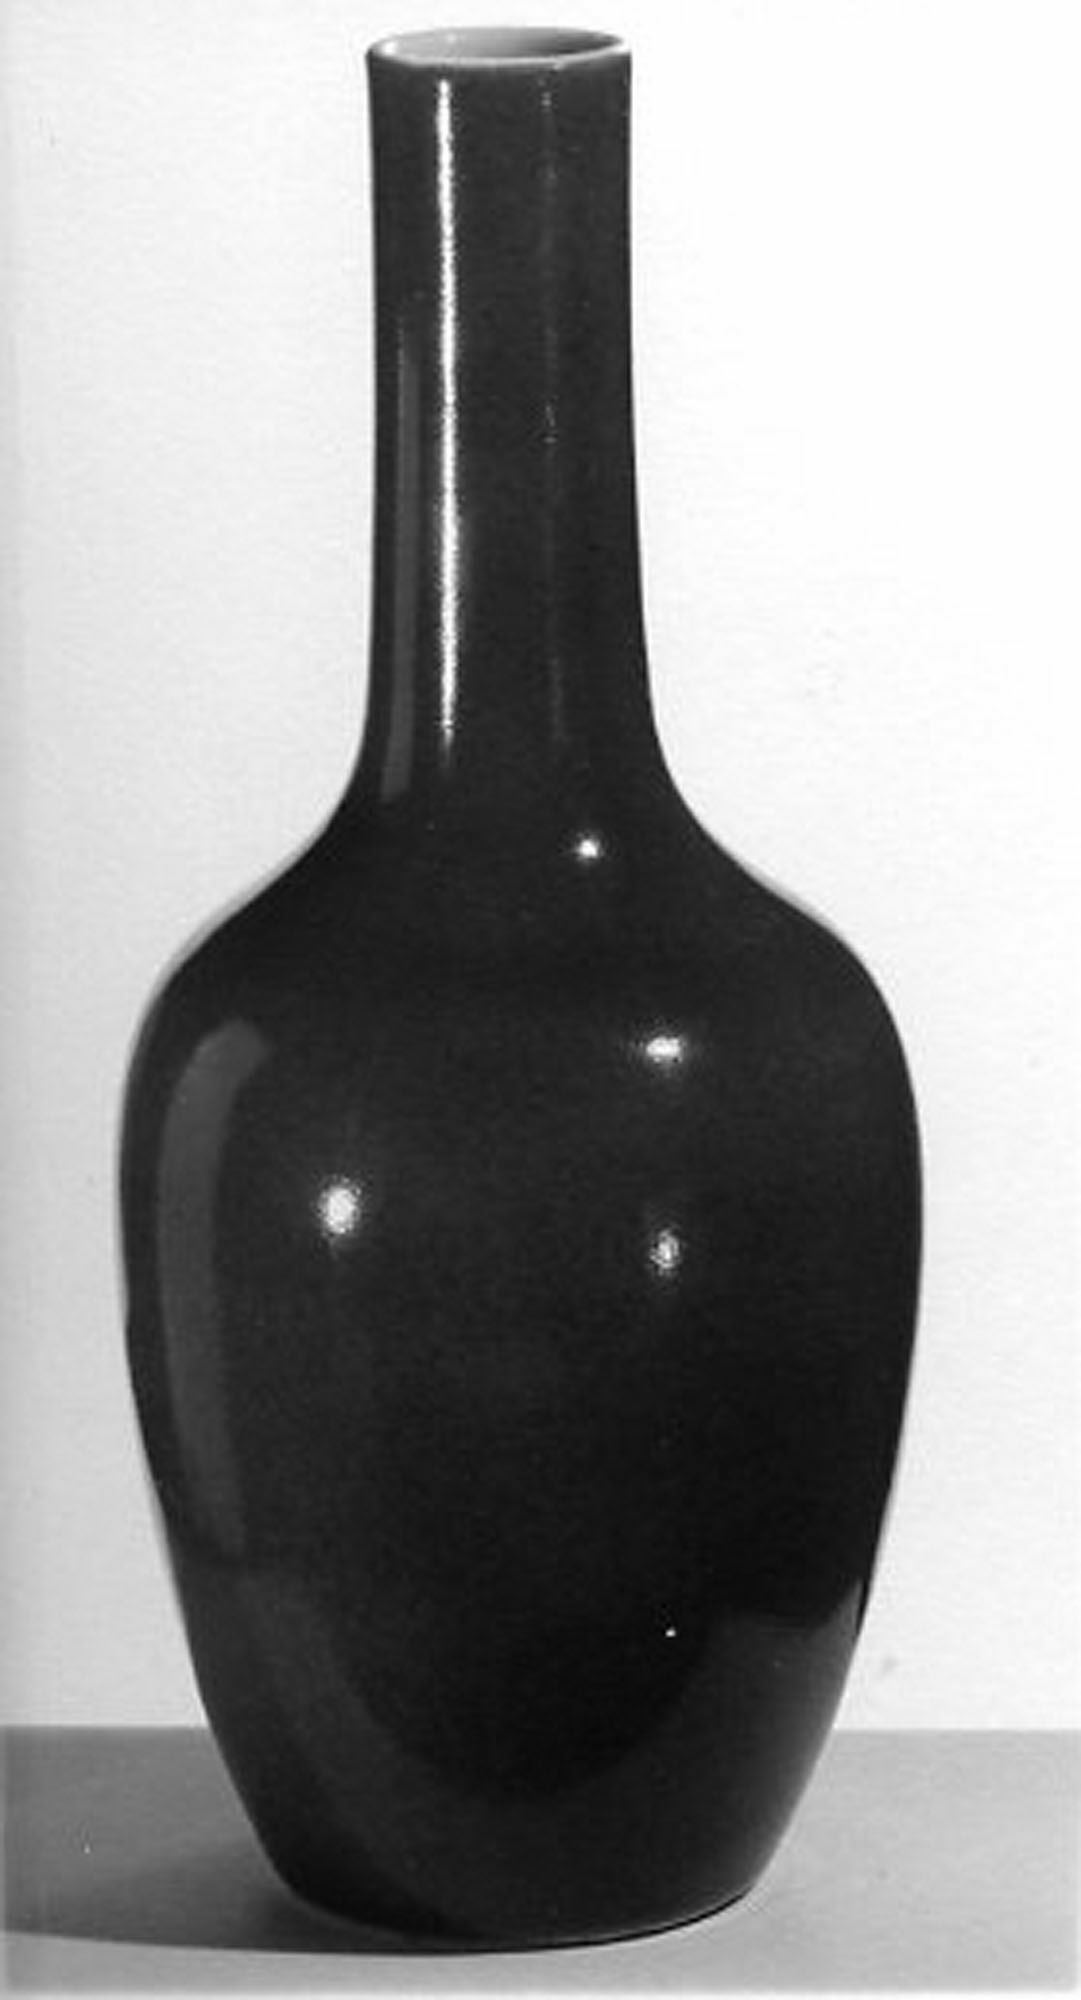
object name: vase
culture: chinese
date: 1736-1795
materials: porcelain